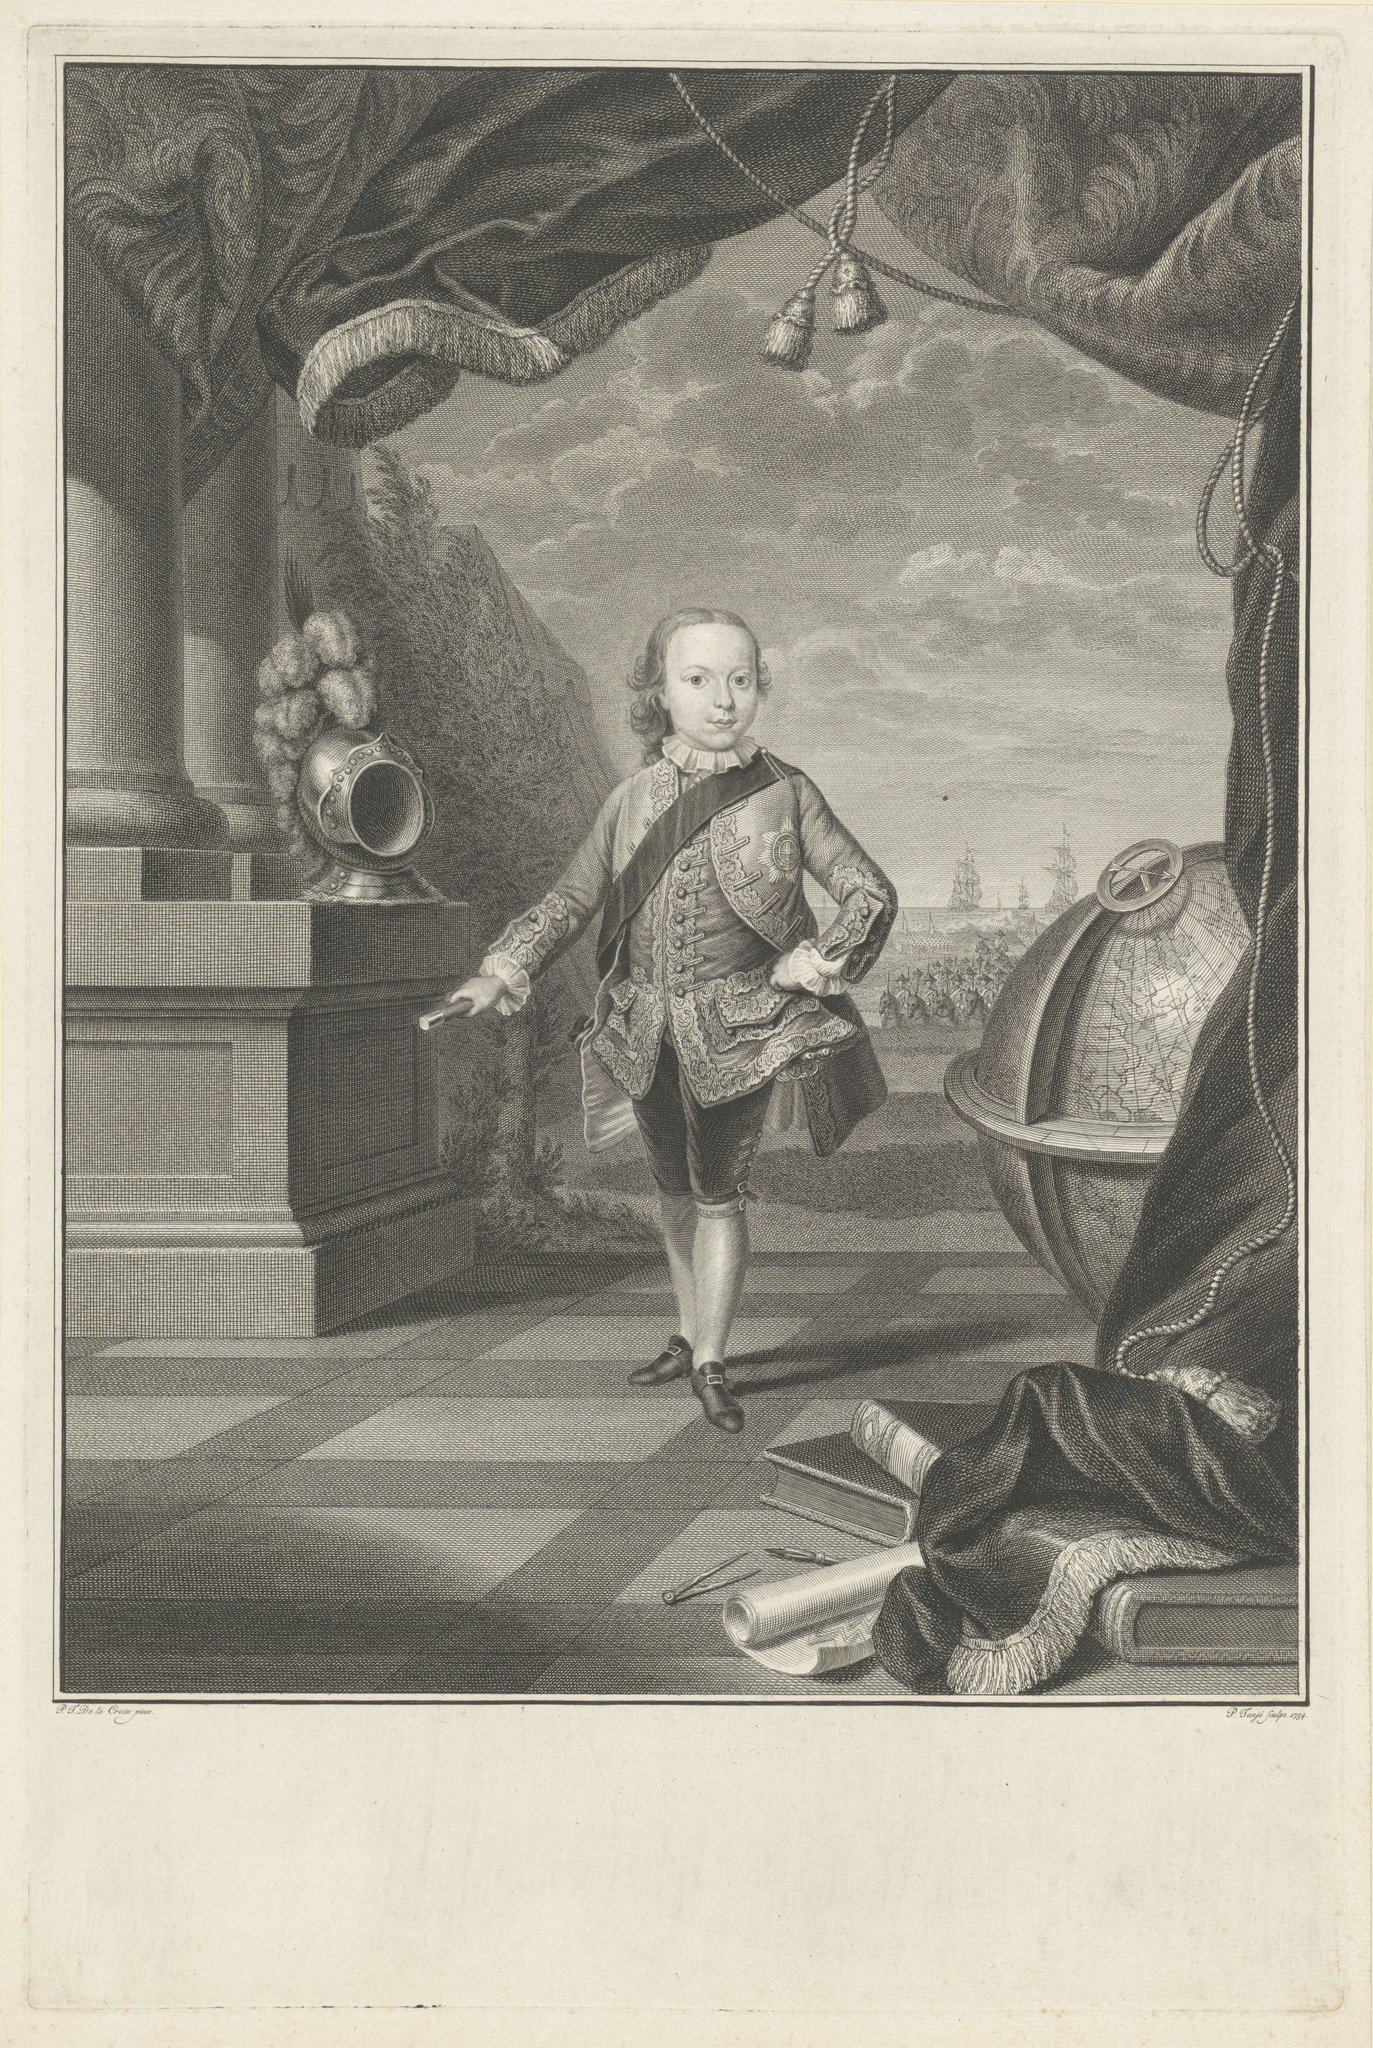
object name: print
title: Portret van Willem V, prins van Oranje-Nassau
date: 1754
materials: paper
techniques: engraving, etching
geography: amsterdam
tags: william v (prince of orange), knighthood order (garter) - insignia of a knighthood order, e.g.: badge, chain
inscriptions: collector's mark: Lugt 240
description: Portret van Willem V. In zijn rechterhand een commandostaf. Op de achtergrond een leger en een vloot. Op de voorgrond een aantal allegorische objecten, waaronder boeken en een wereldbol.